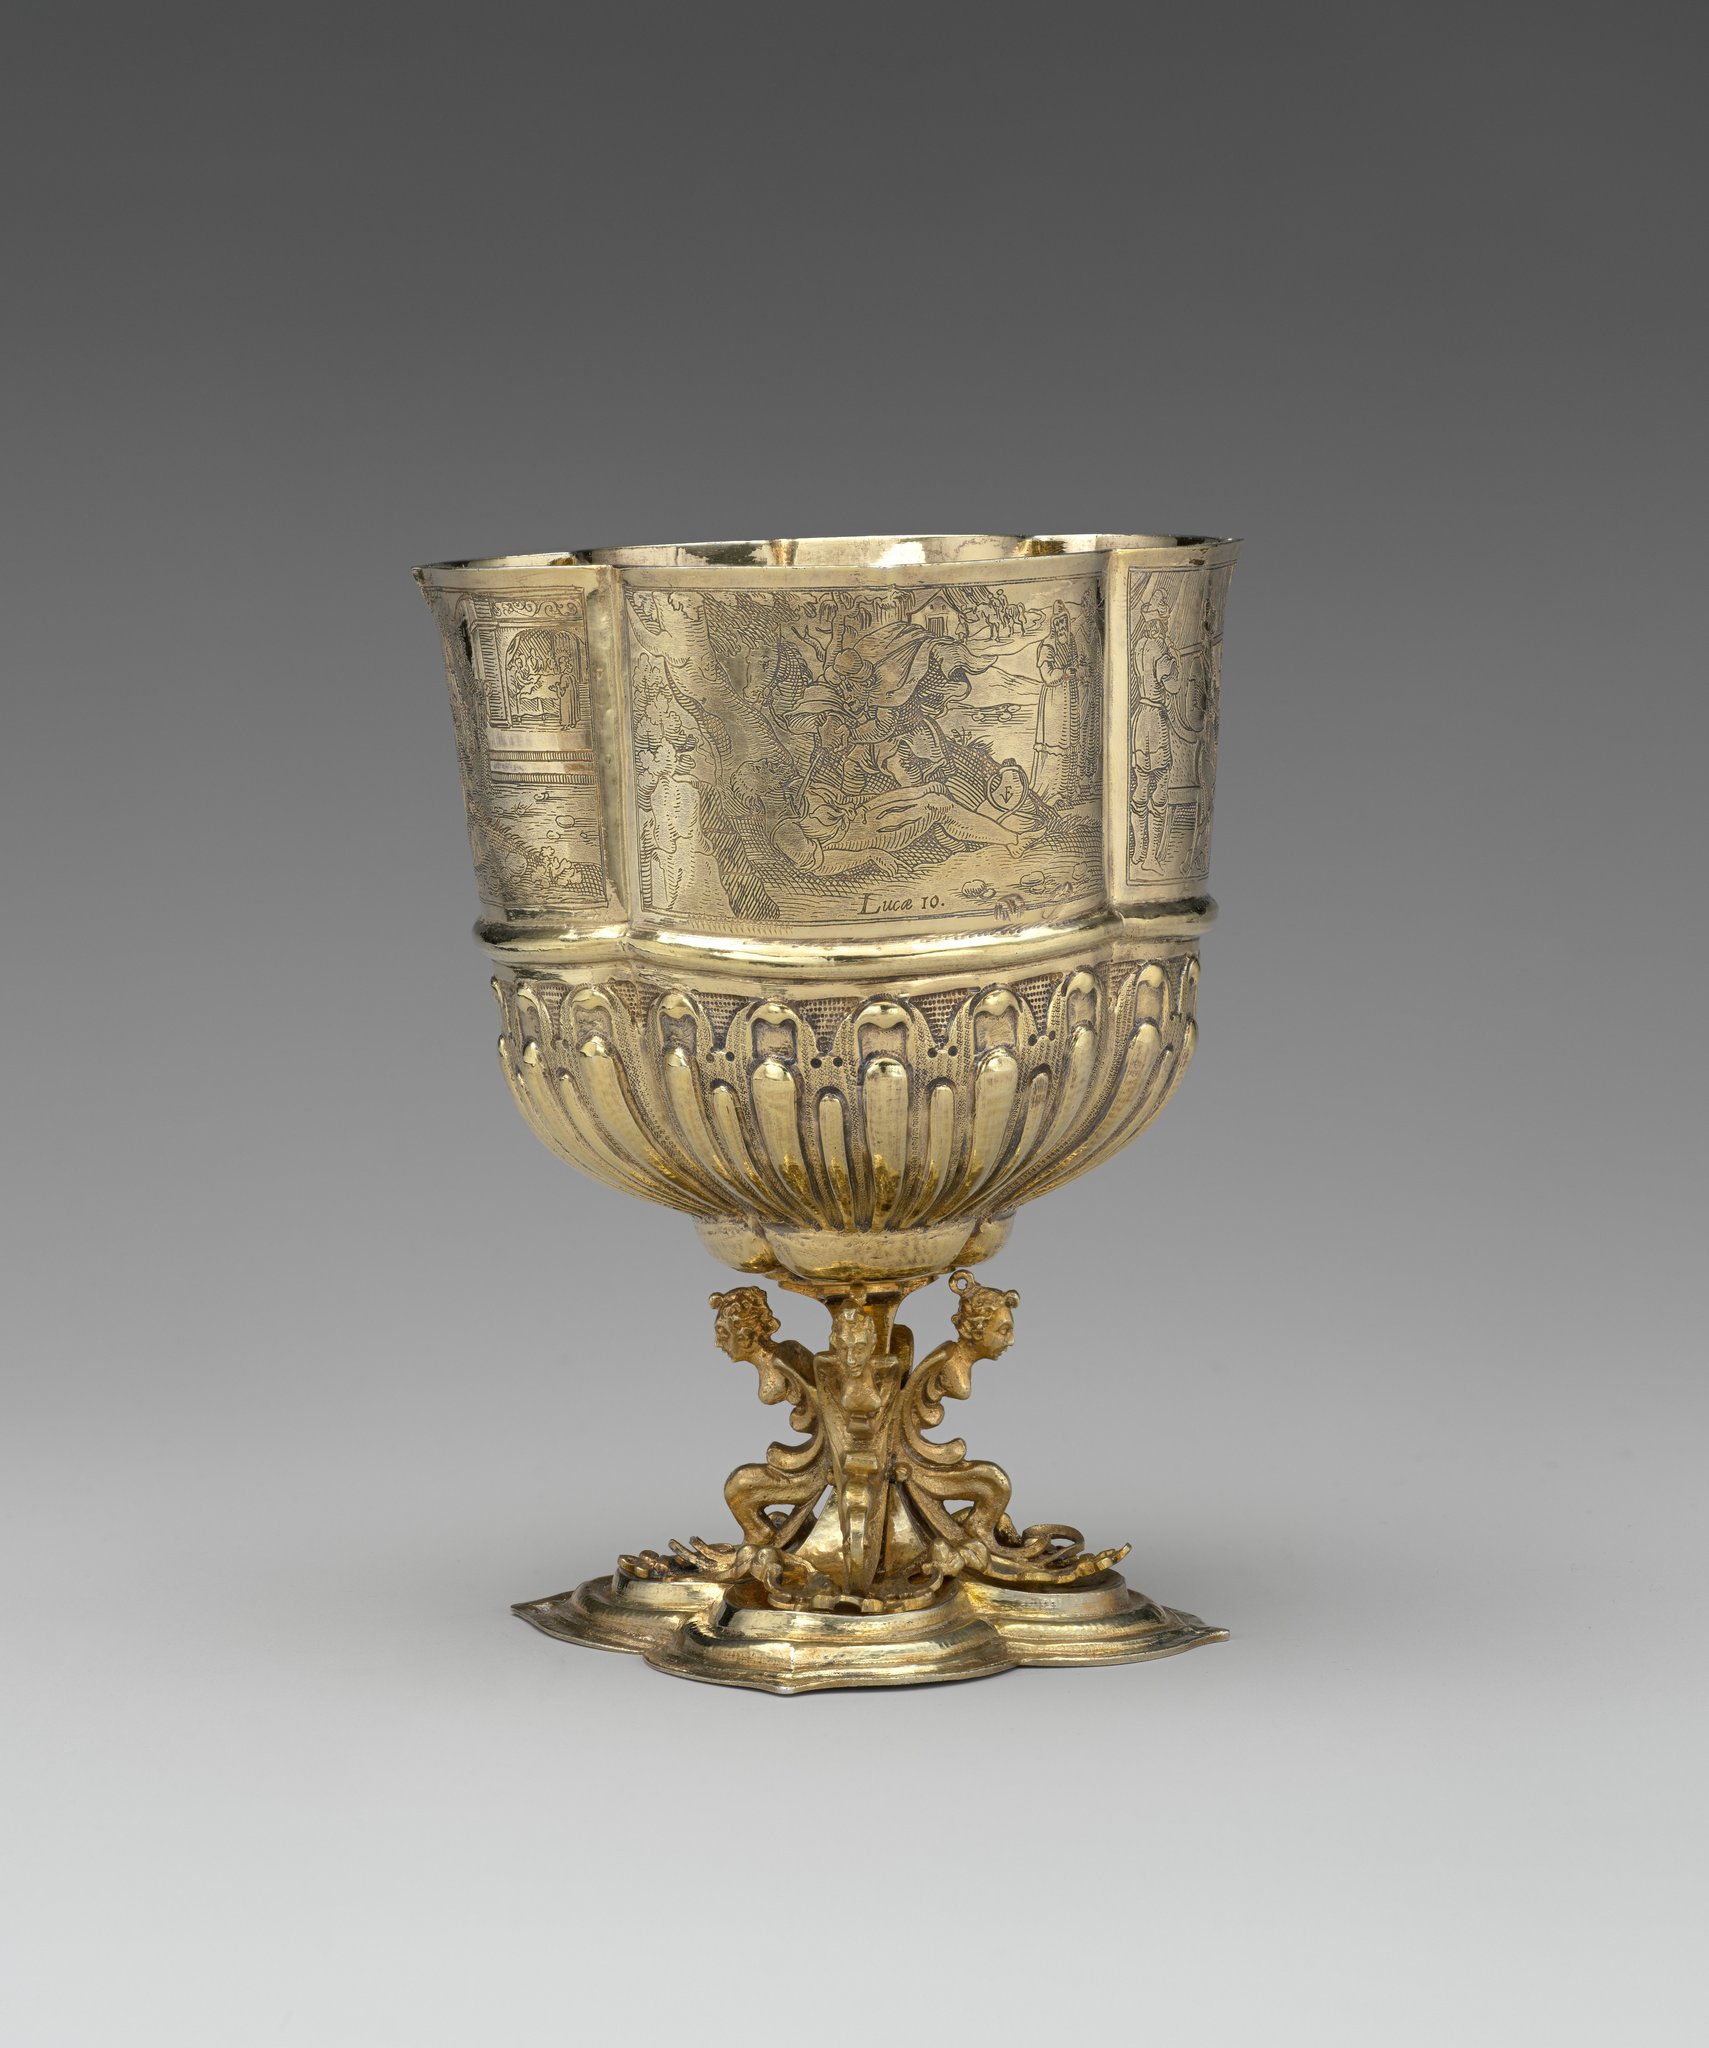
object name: cup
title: Cup with scenes from the New Testament (one of a pair)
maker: franz fischer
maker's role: maker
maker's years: 1553-1653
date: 1601-1633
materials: silver gilt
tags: men,women